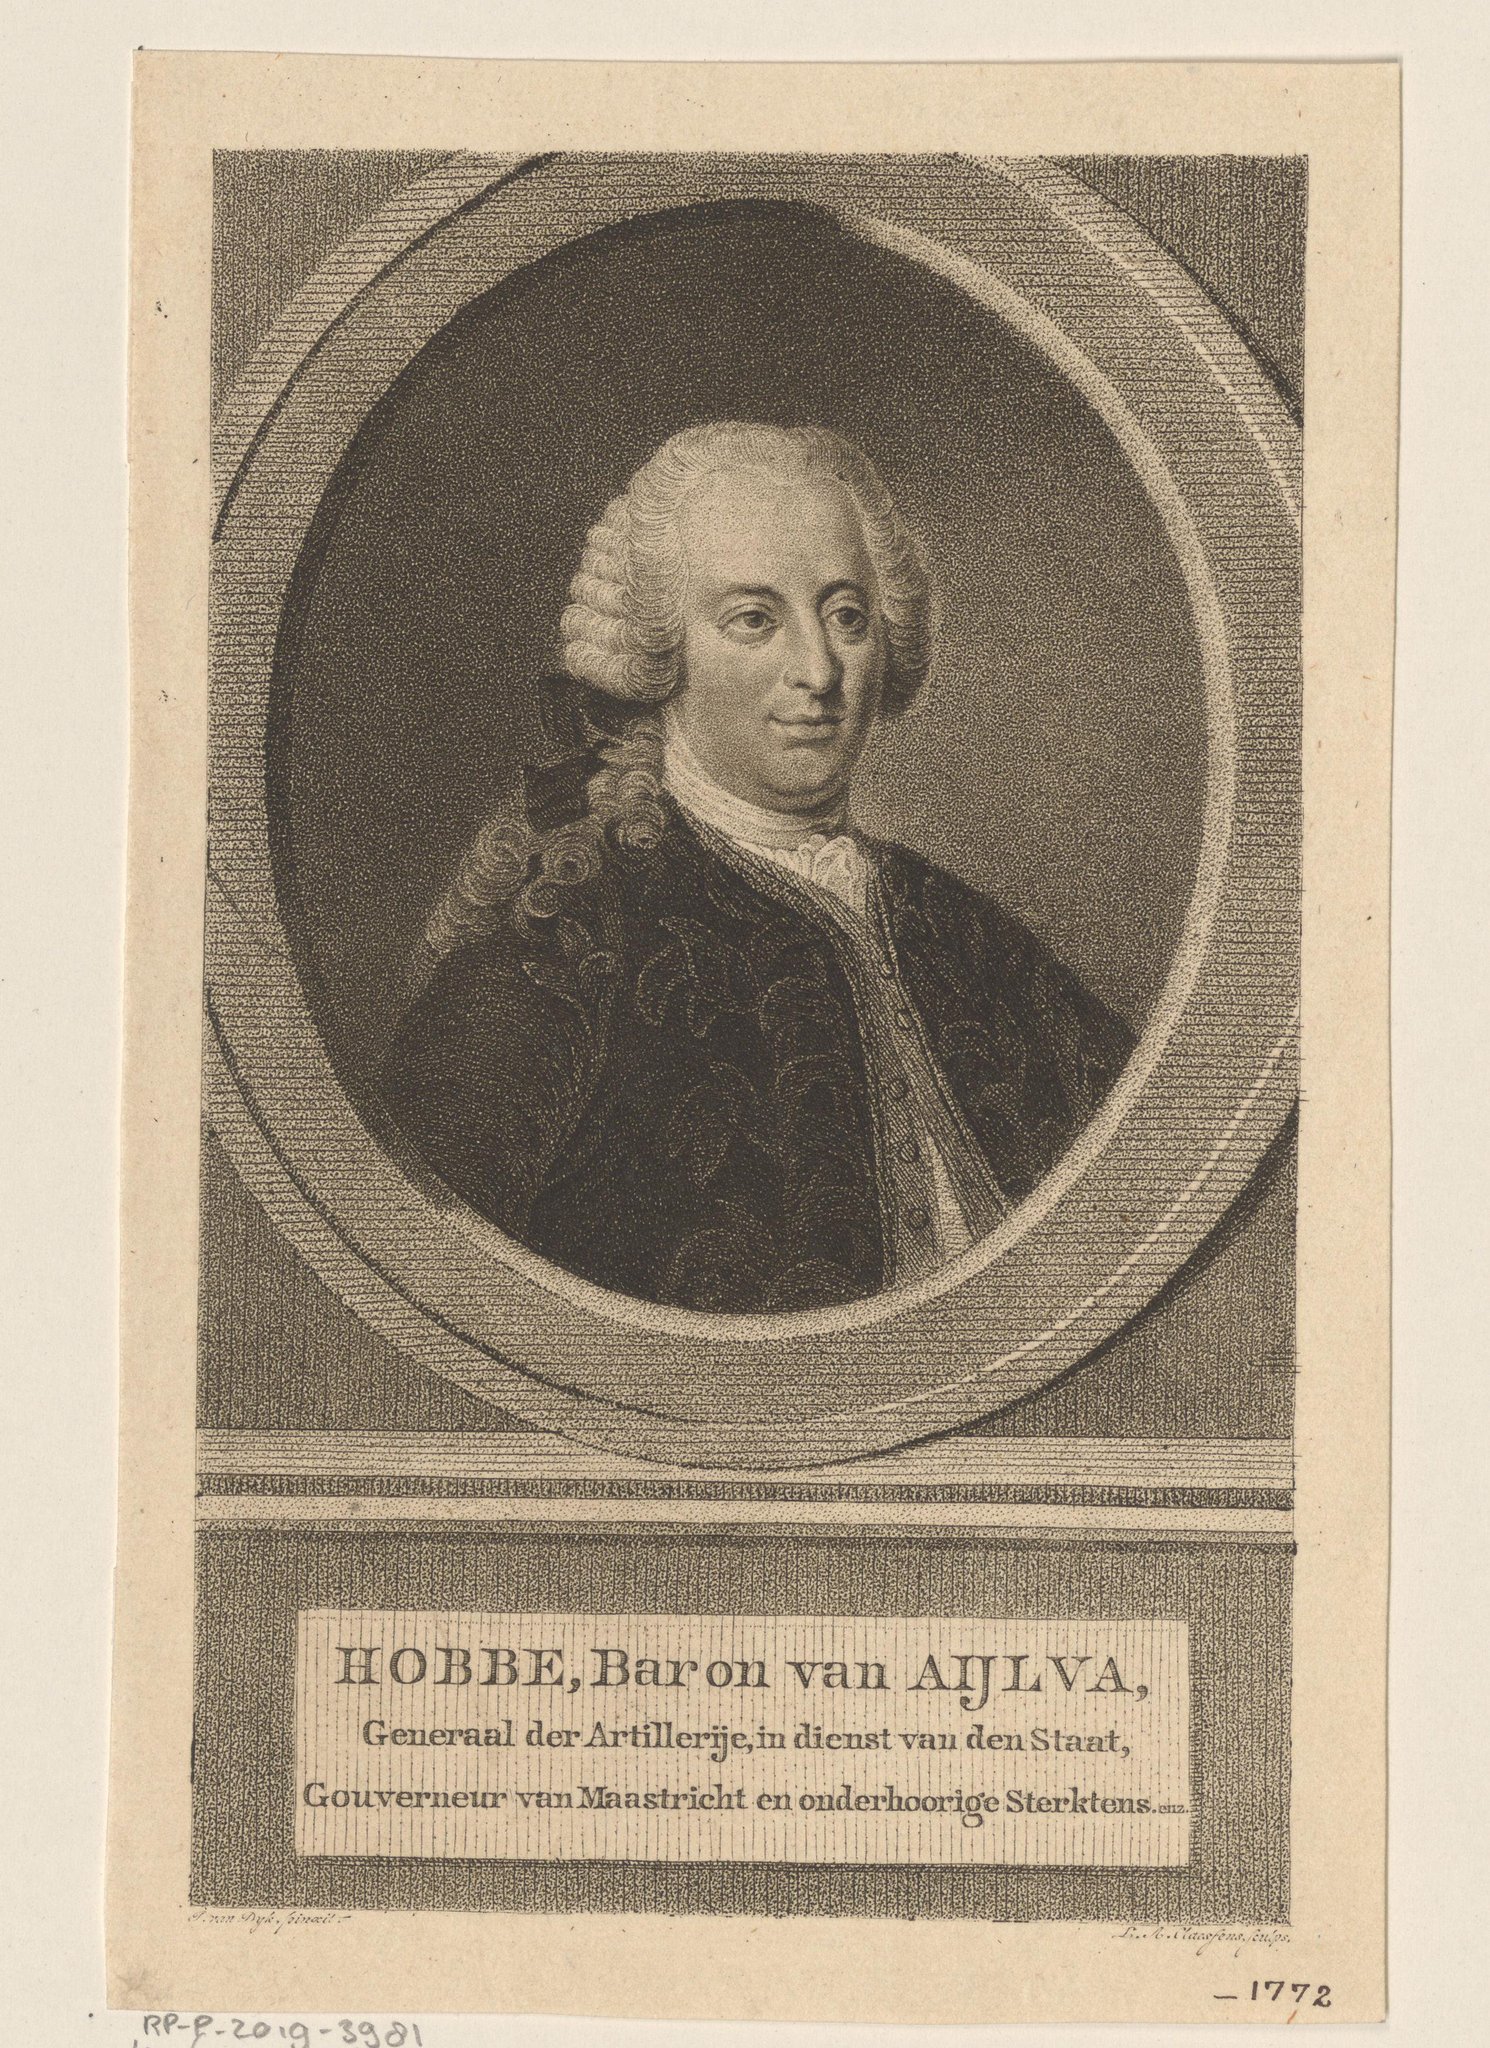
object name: print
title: Portret van Hobbe Esaias, baron van Avyla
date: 1773-1843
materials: paper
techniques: etching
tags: maastricht, hobbe esaias baron van aylva, historical persons